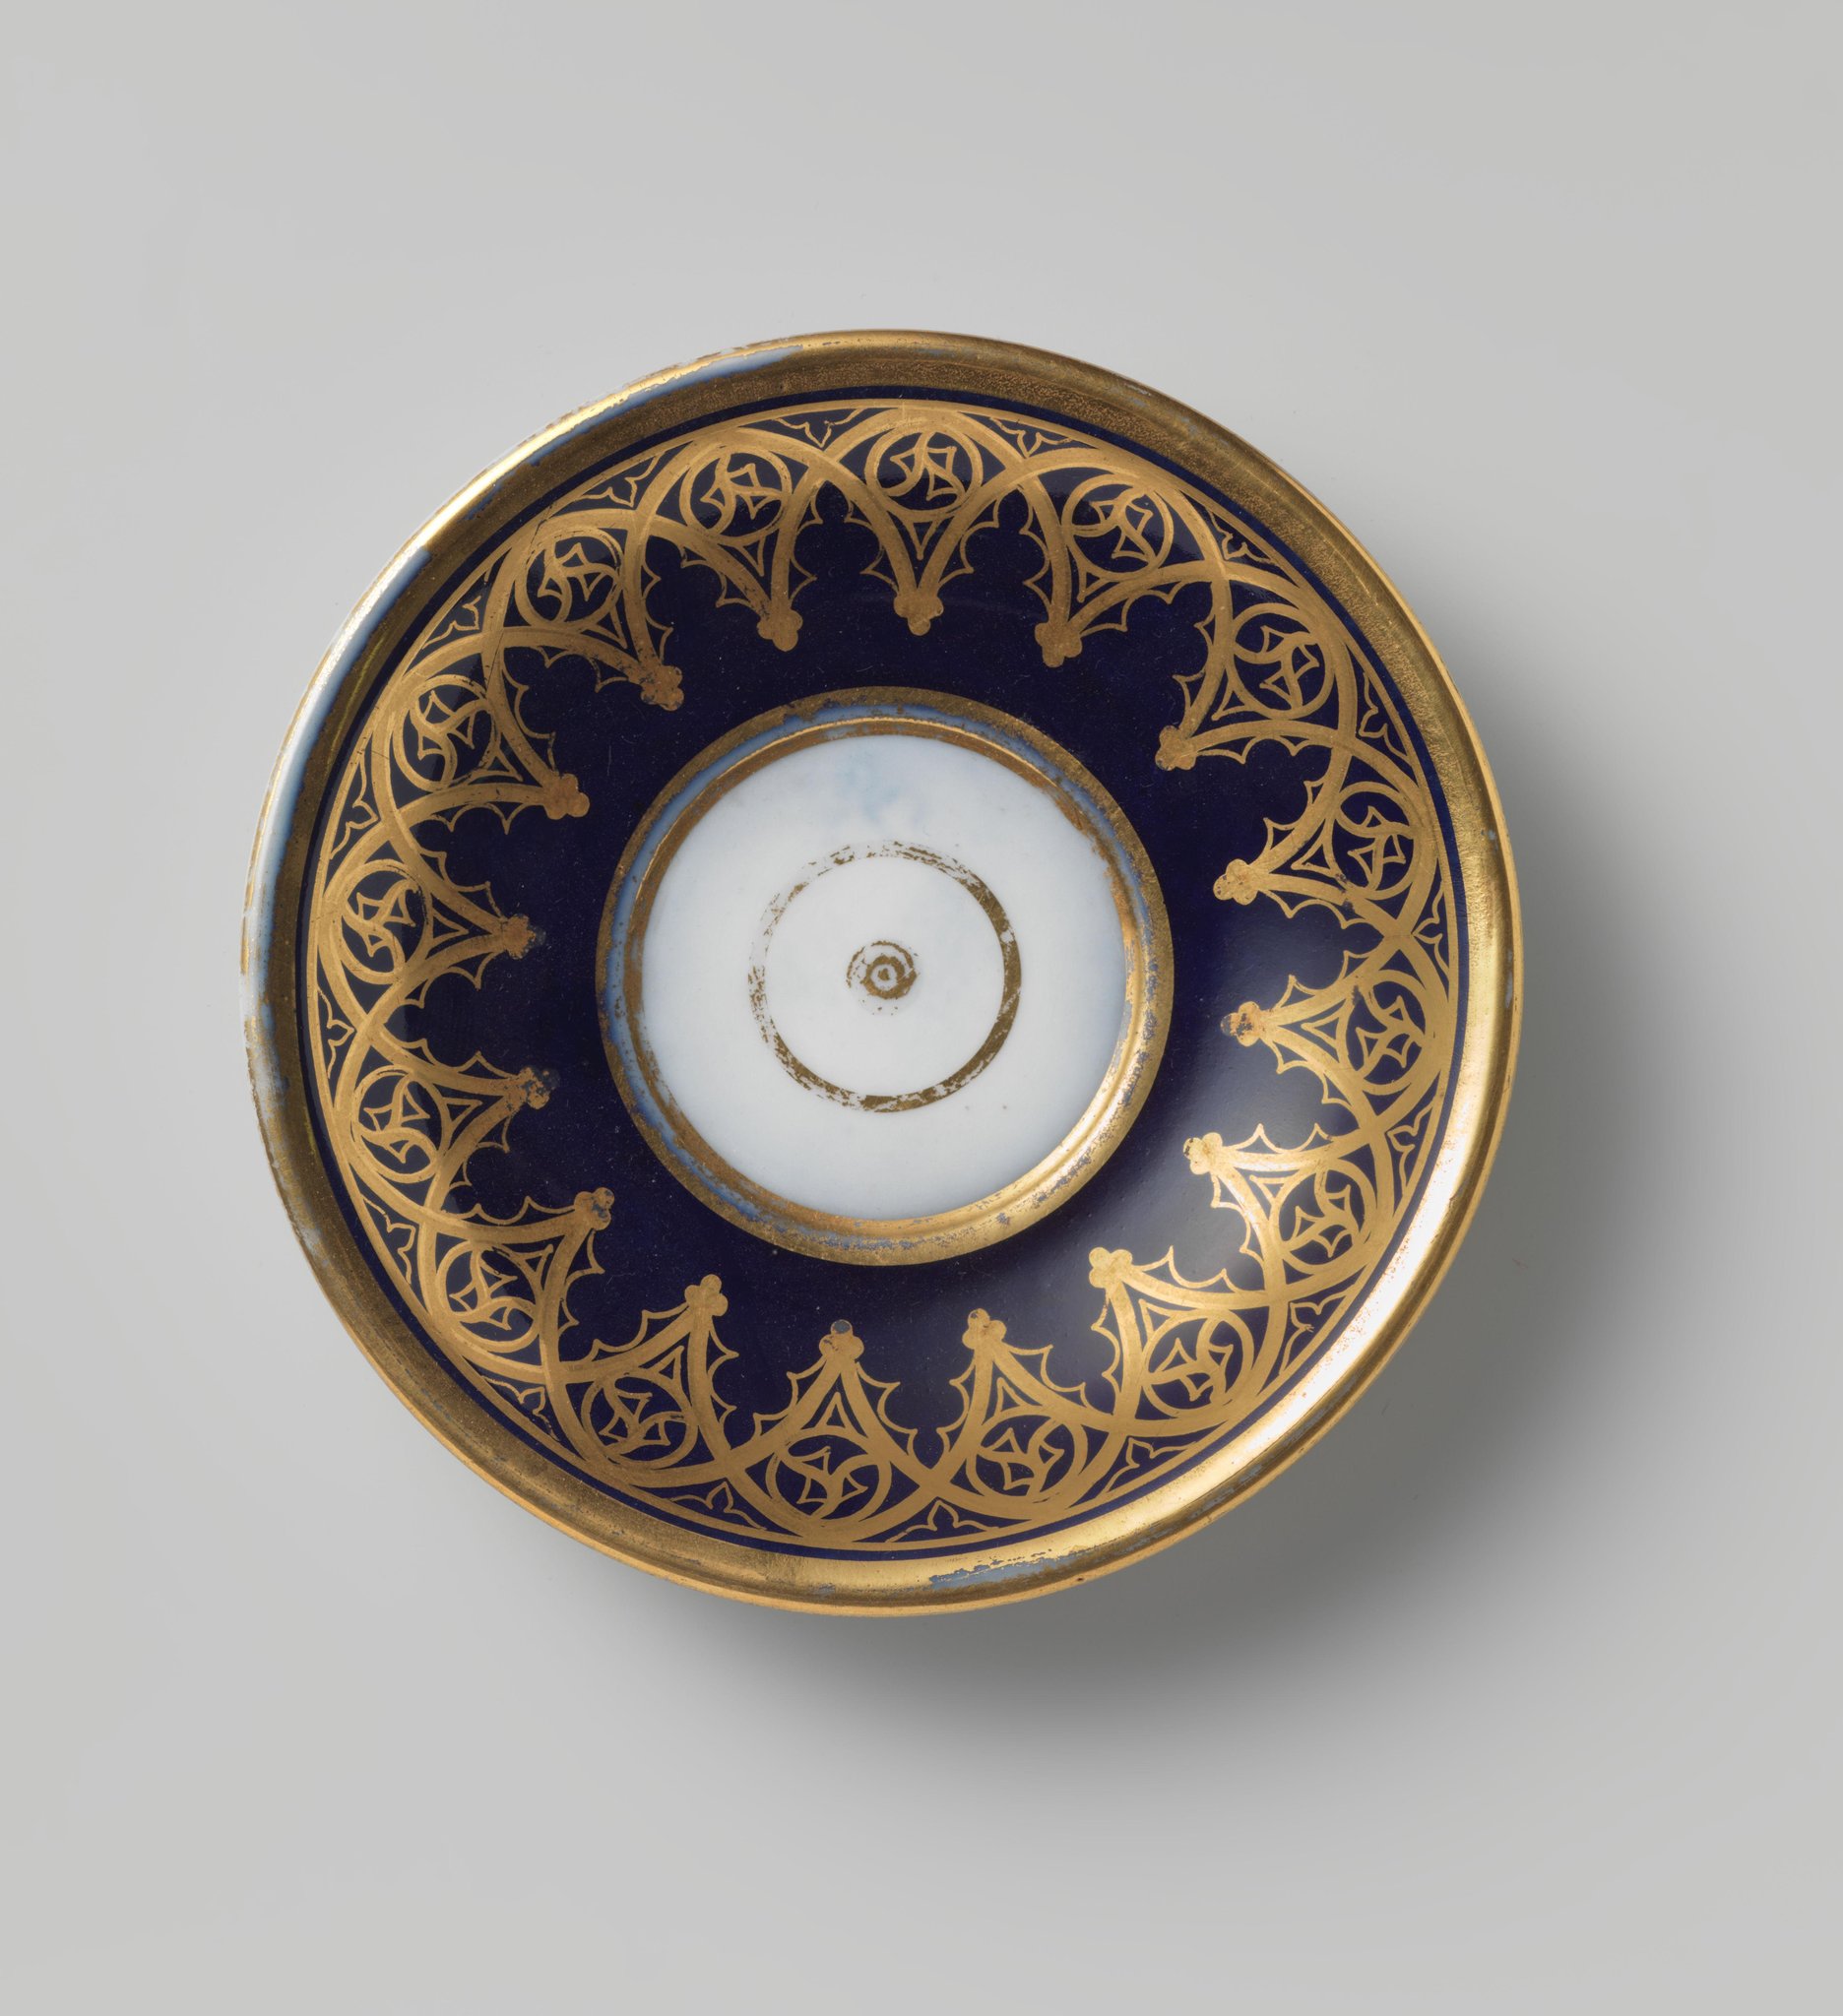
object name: platter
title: Saucer with a gothic arcade decoration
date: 1800-1899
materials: cobalt, glaze, gold, paint, porcelain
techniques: firing, forming, gilding, turning, vitrification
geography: saint-yrieix-la-perche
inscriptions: mark: ‘vis’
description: Schotel van porselein, deel van servies, beschilderd in goud op een koningsblauw fond met een arcademotief met gotische traceringen. Buiten dit decor en voor een groot deel aan de binnenzijde verguld. Gemerkt met een groen visje. Opmerking: zie voor merken ook het algemeen record.